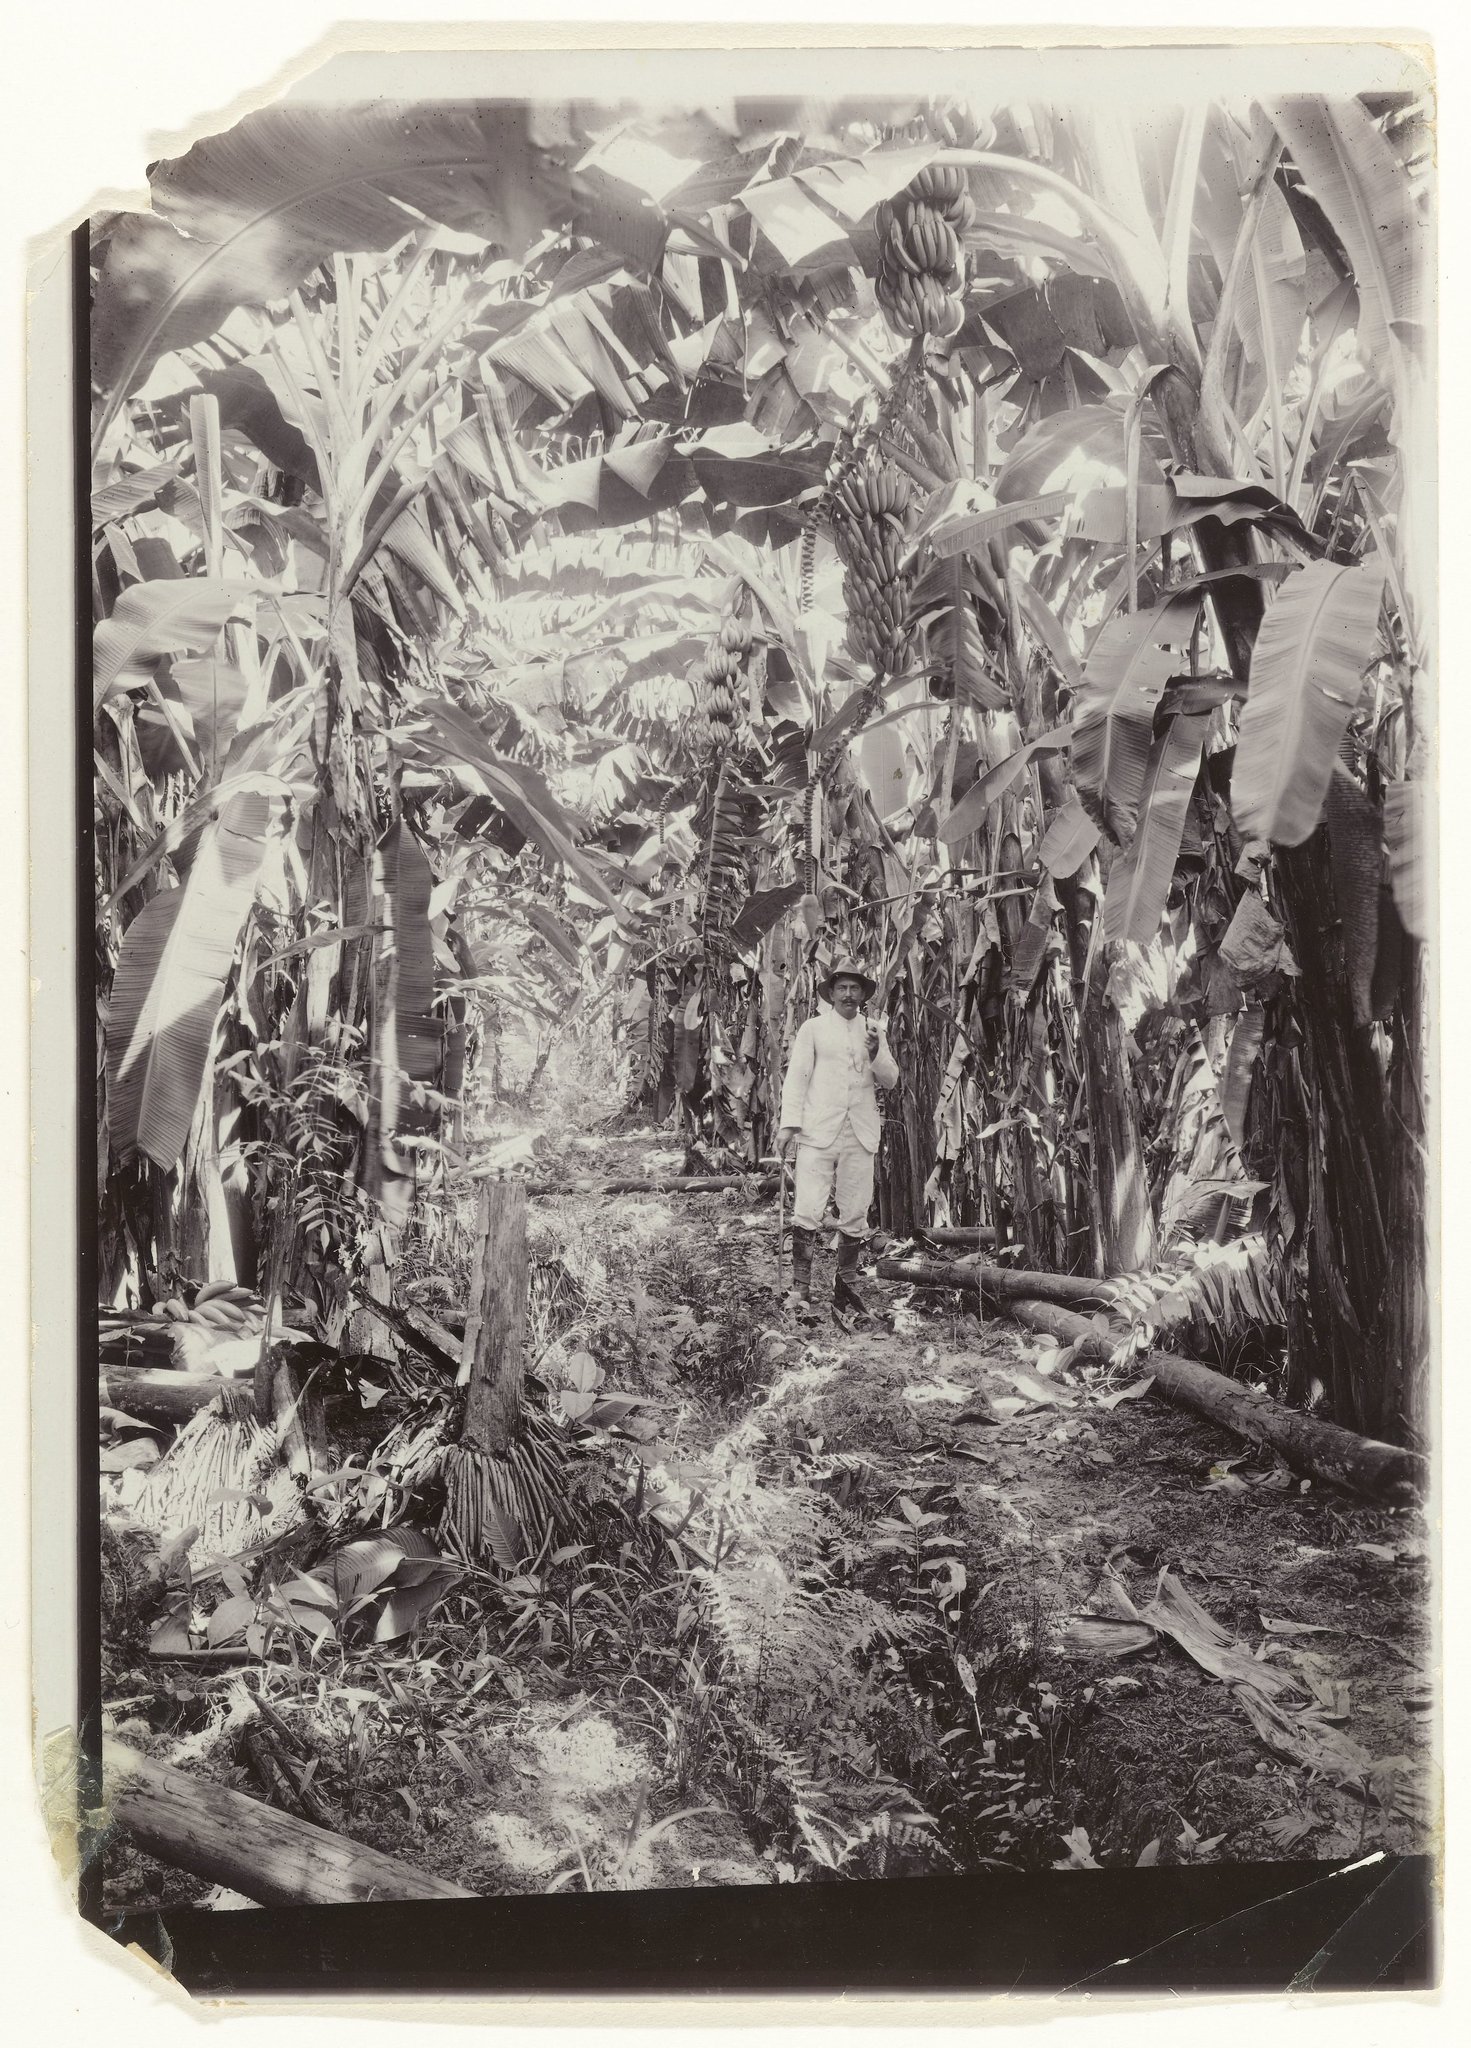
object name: photograph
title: Theodorus Johannes Brouwers tussen de bananenbomen op plantage Accaribo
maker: Anonymous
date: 1915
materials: photographic support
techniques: gelatin silver print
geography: suriname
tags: amsterdam, theodoor brouwers, suriname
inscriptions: inscription: ‘Vader in de bacovetijd (Gros M...’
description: In de periode 1911-1932 woonde op plantage Accaribo in Suriname de familie Brouwers van wie de foto's afkomstig zijn. Rond 1910 vond Theodoor Brouwers werk op plantage Accaribo. In 1929 werd hij eigenaar van de plantage.